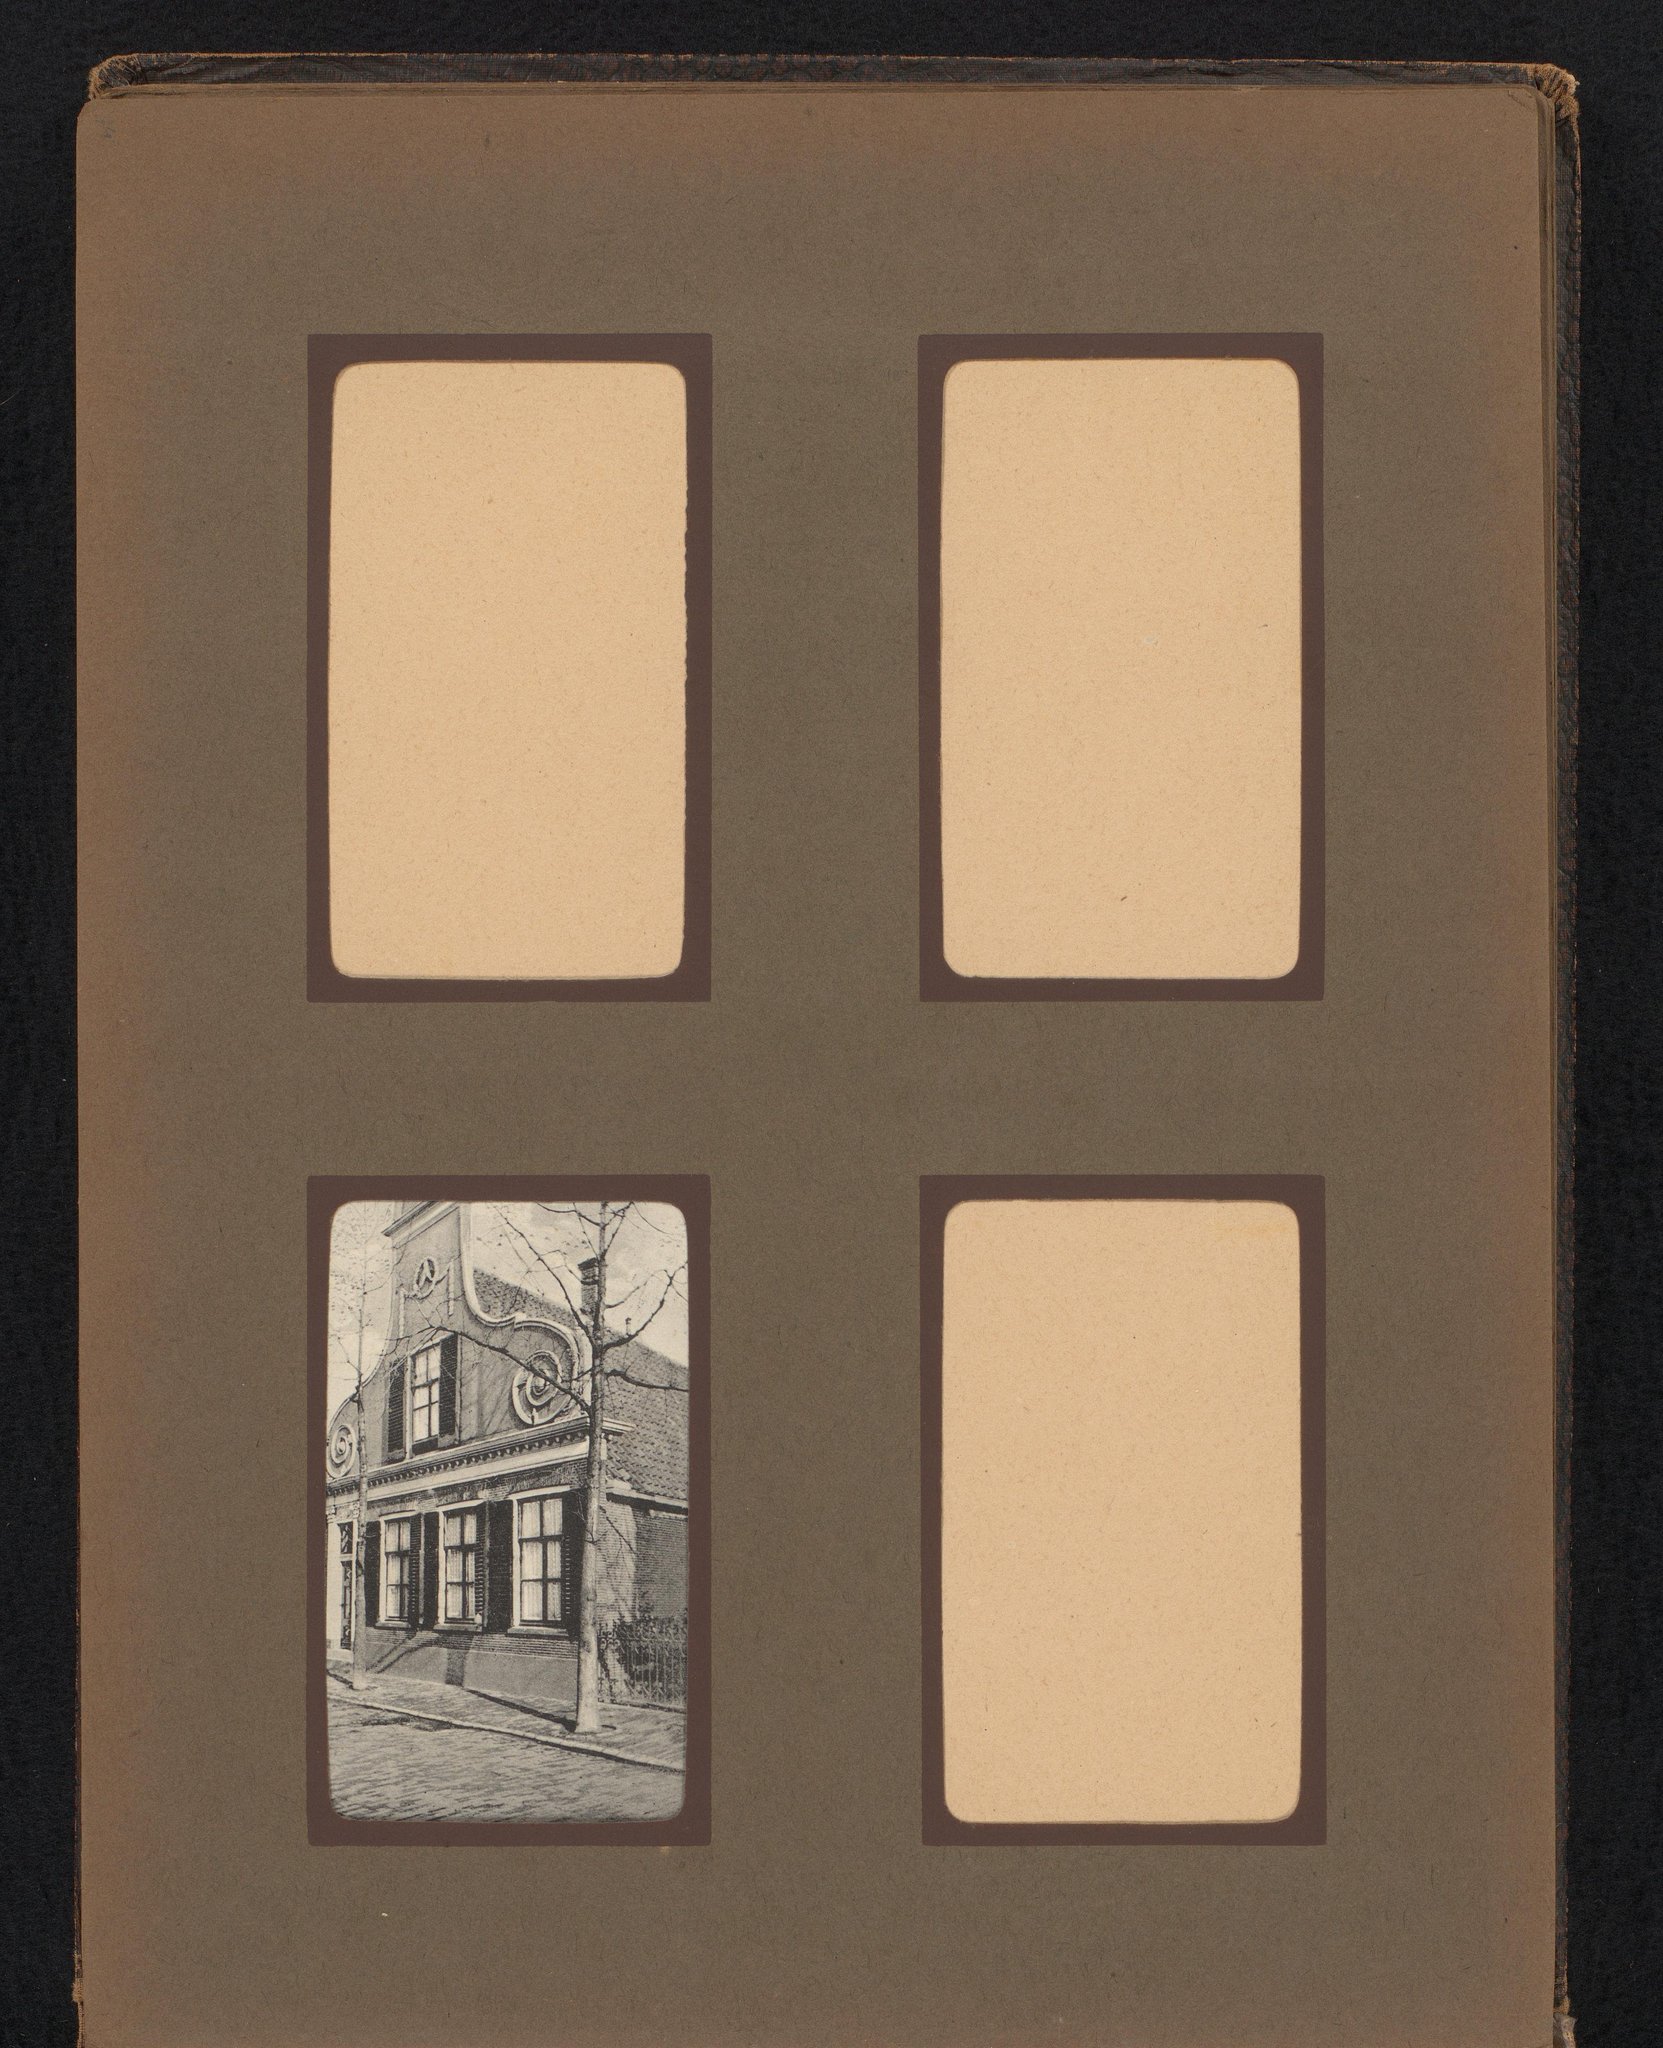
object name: photomechanical print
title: Oude gevel - Krommenie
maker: Anonymous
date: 1920-1937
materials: cardboard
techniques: photograph, writing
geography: krommenie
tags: urban housing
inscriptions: inscription: ‘Geboortehuis van/ Guurtje van Leyden’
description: Deze prent maakt deel uit van een album.